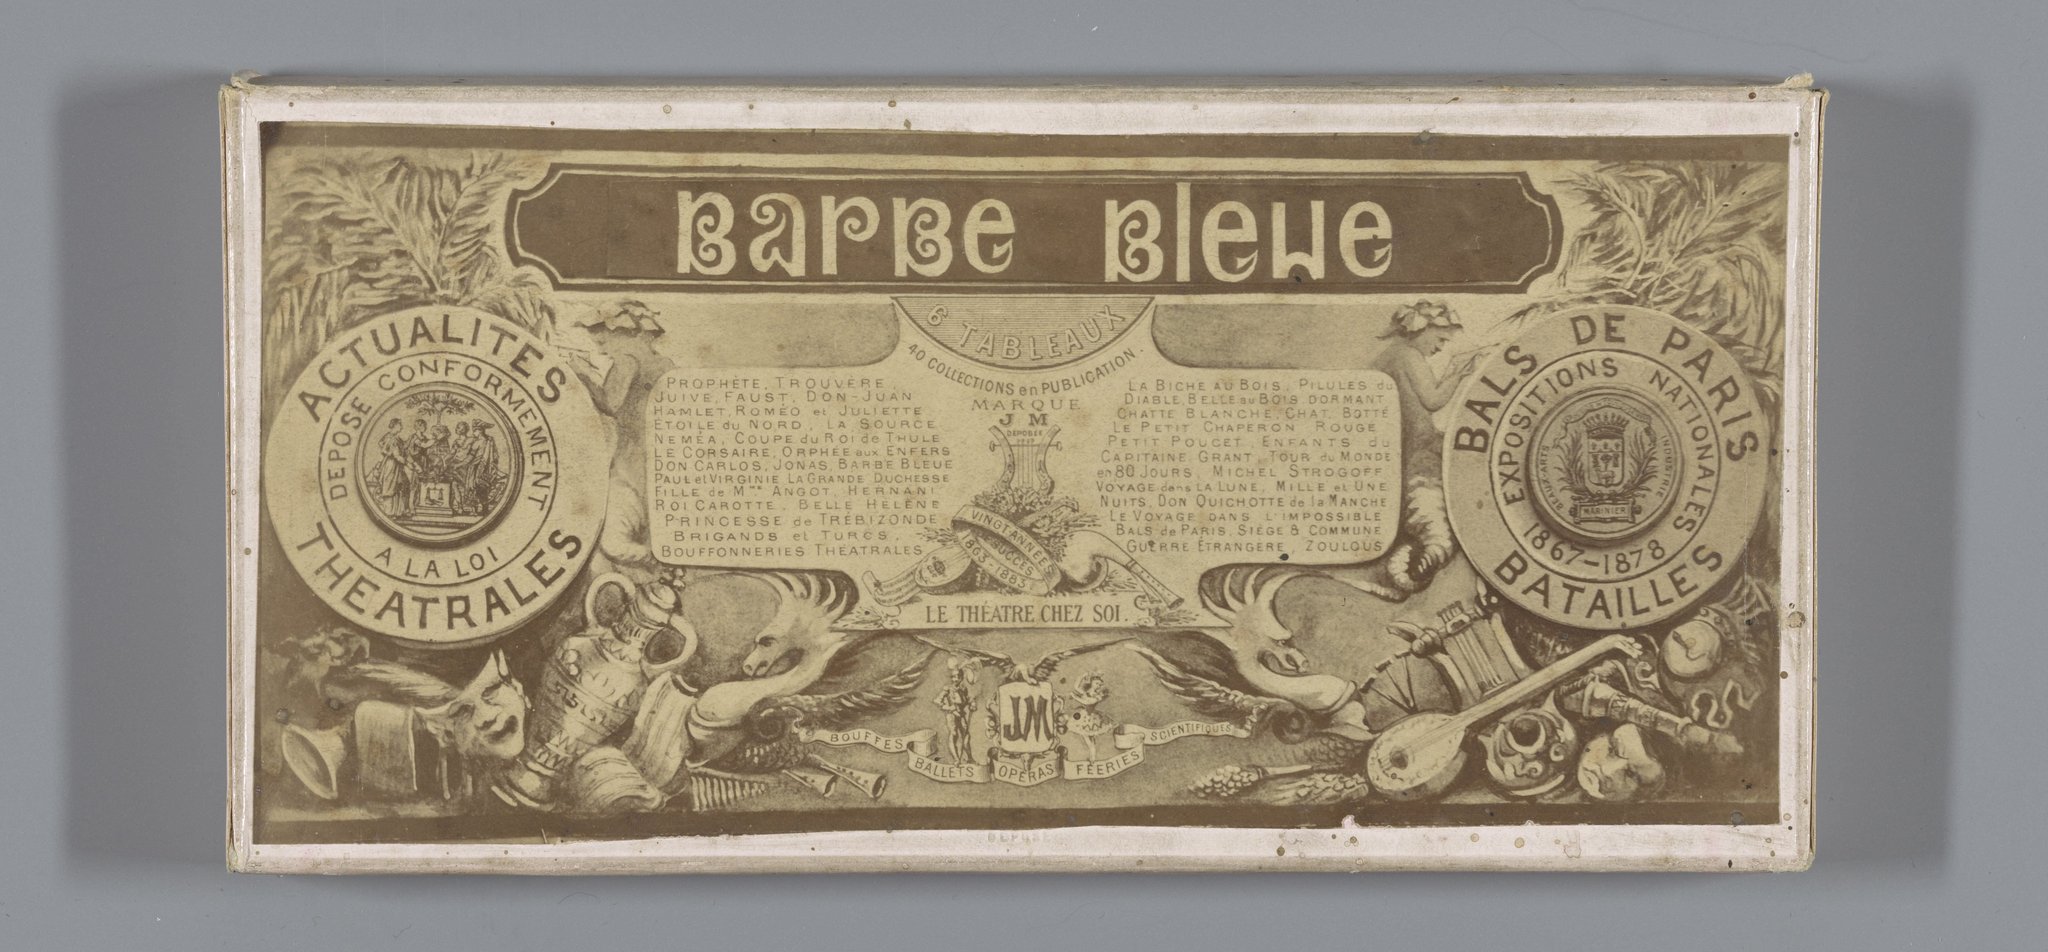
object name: box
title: Doos ter verpakking van 6 stereofoto's van het theater in Parijs Barbe bleue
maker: Anonymous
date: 1867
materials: cardboard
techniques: printing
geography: paris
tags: group of actors, troupe; actors on the stage, paris